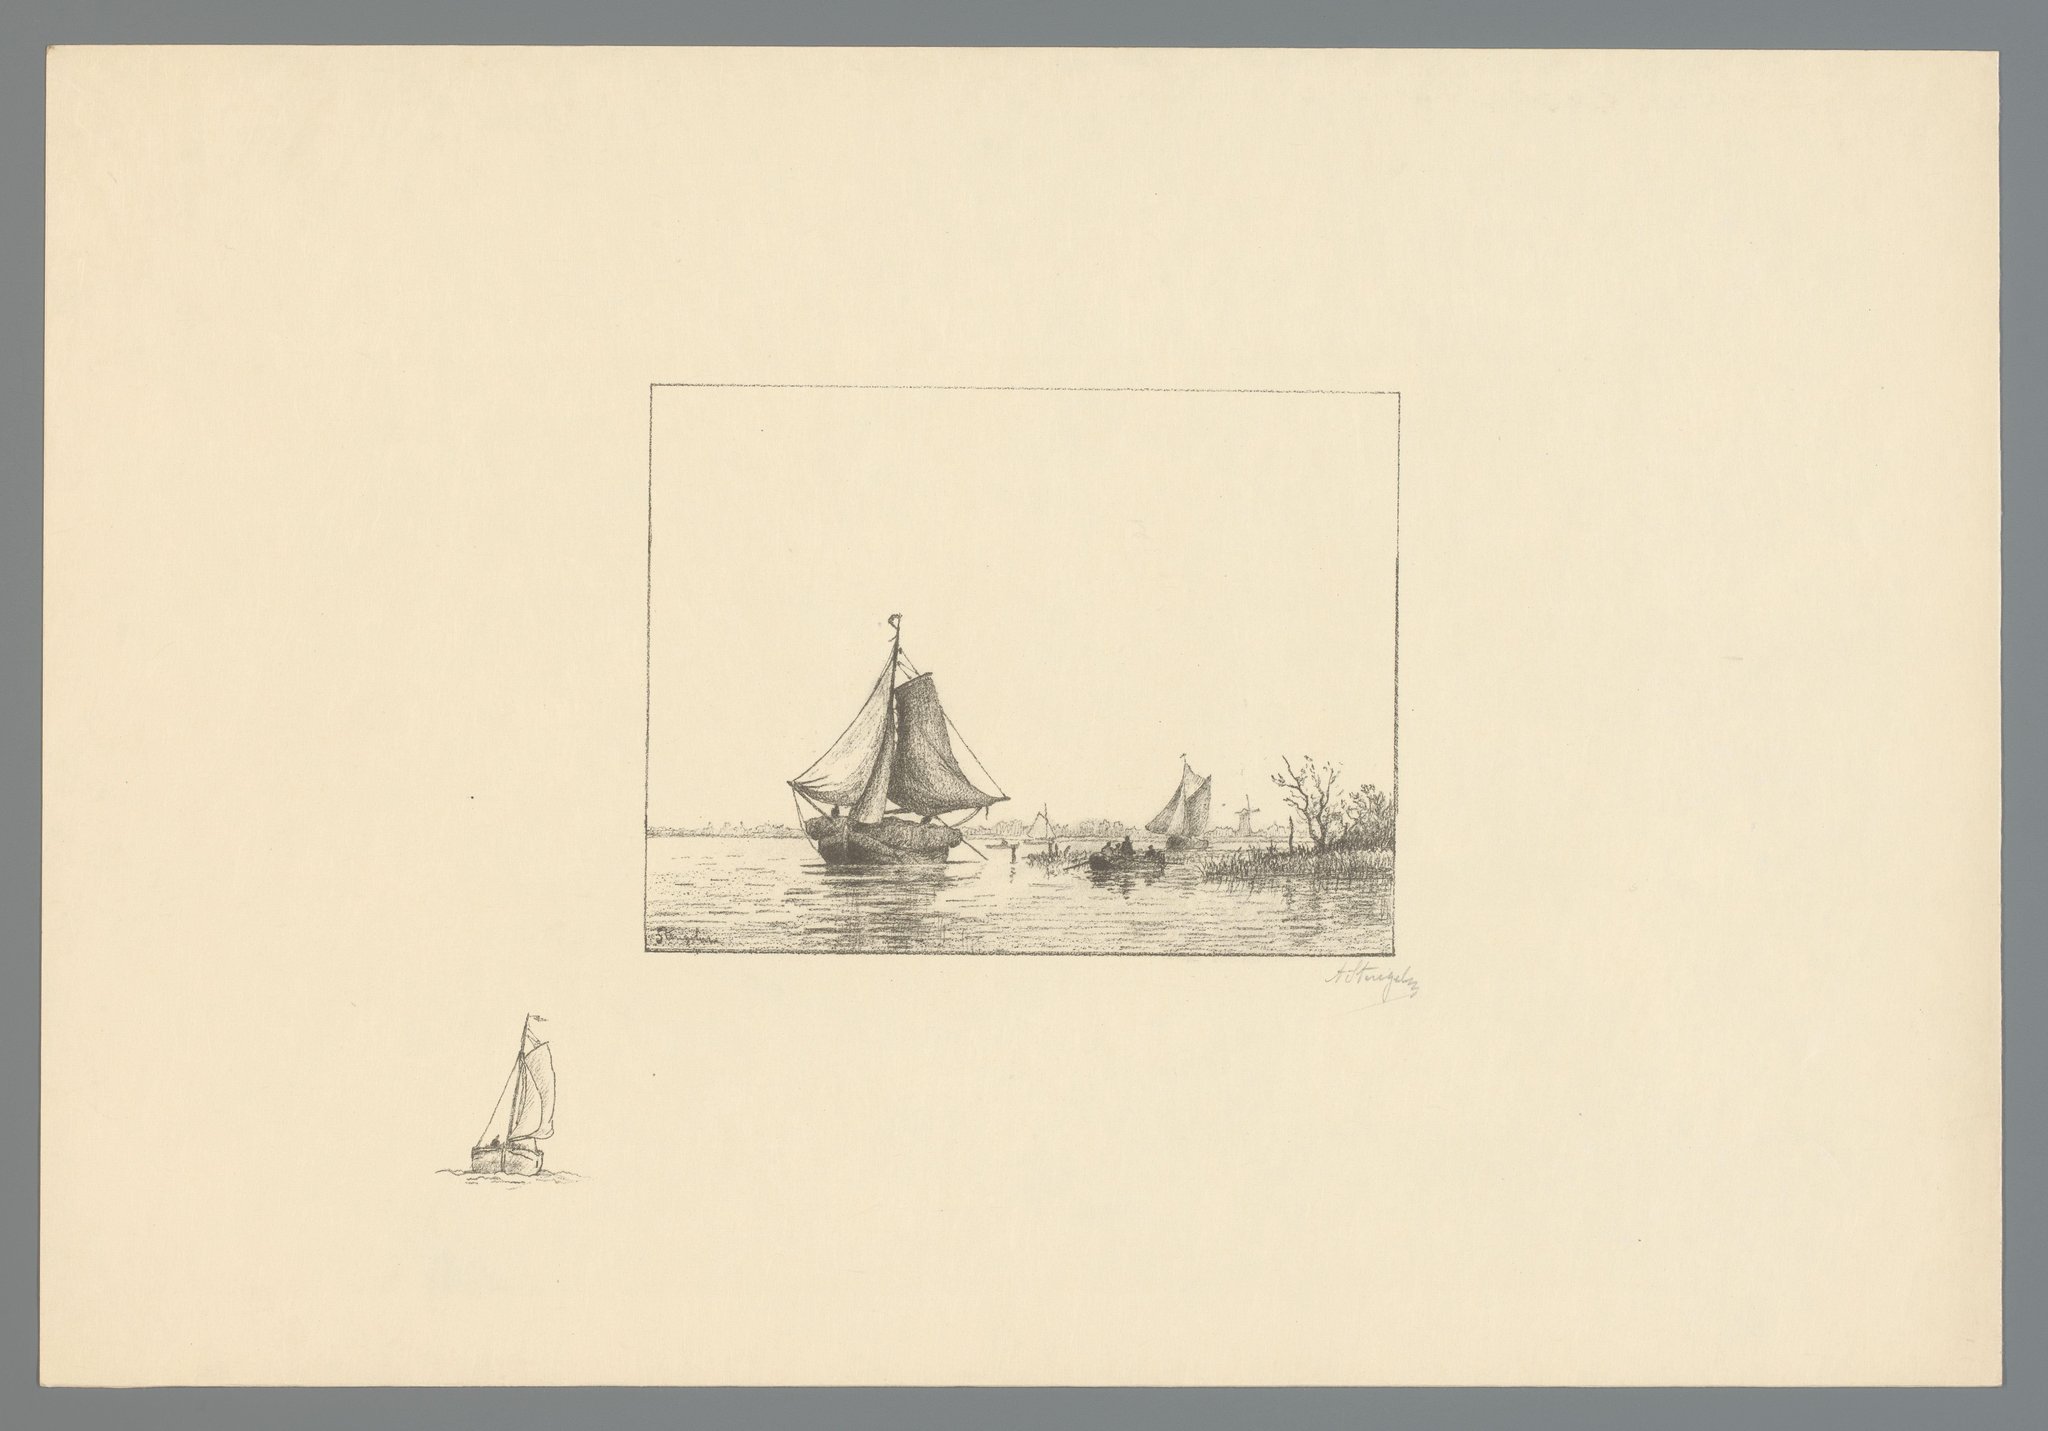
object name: print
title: Meuse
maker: alphonse stengelin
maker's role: painter, print maker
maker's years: 1852-1938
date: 1876-1910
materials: paper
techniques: lithograph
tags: sailing-ship, sailing-boat, river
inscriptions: collector's mark: Lugt 2228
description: Linksonder een remarque met een zeilboot.